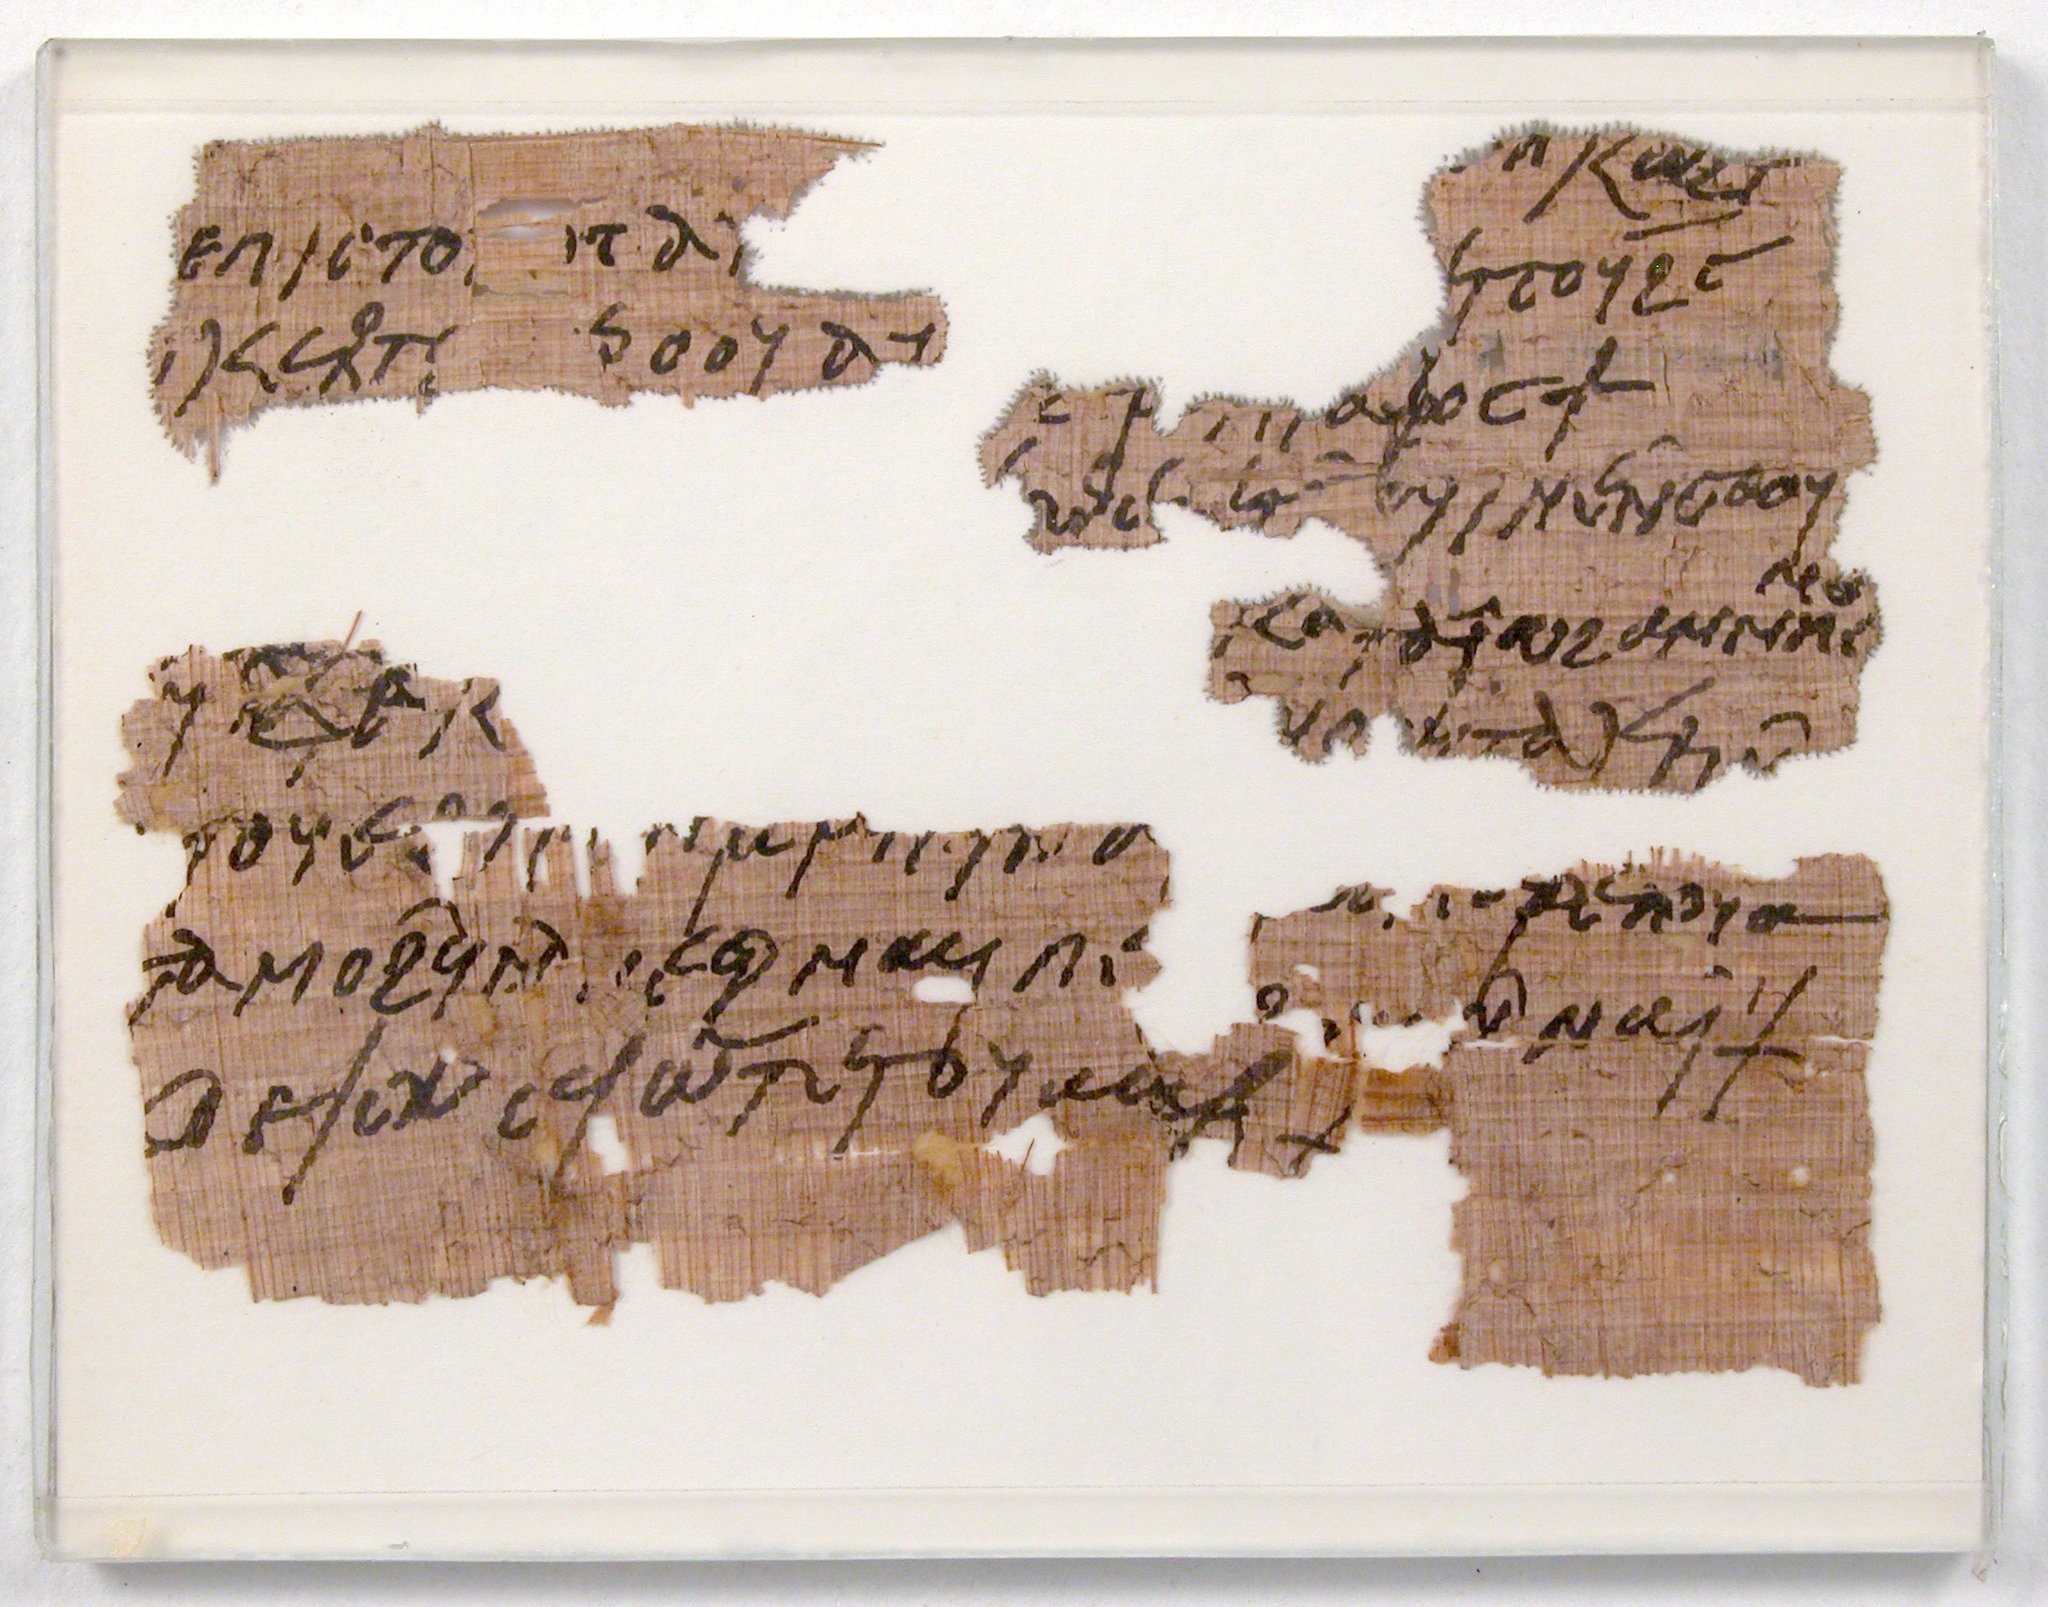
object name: fragment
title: Papyri Fragments of a Letter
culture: coptic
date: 601-700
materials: ink, papyrus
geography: egypt